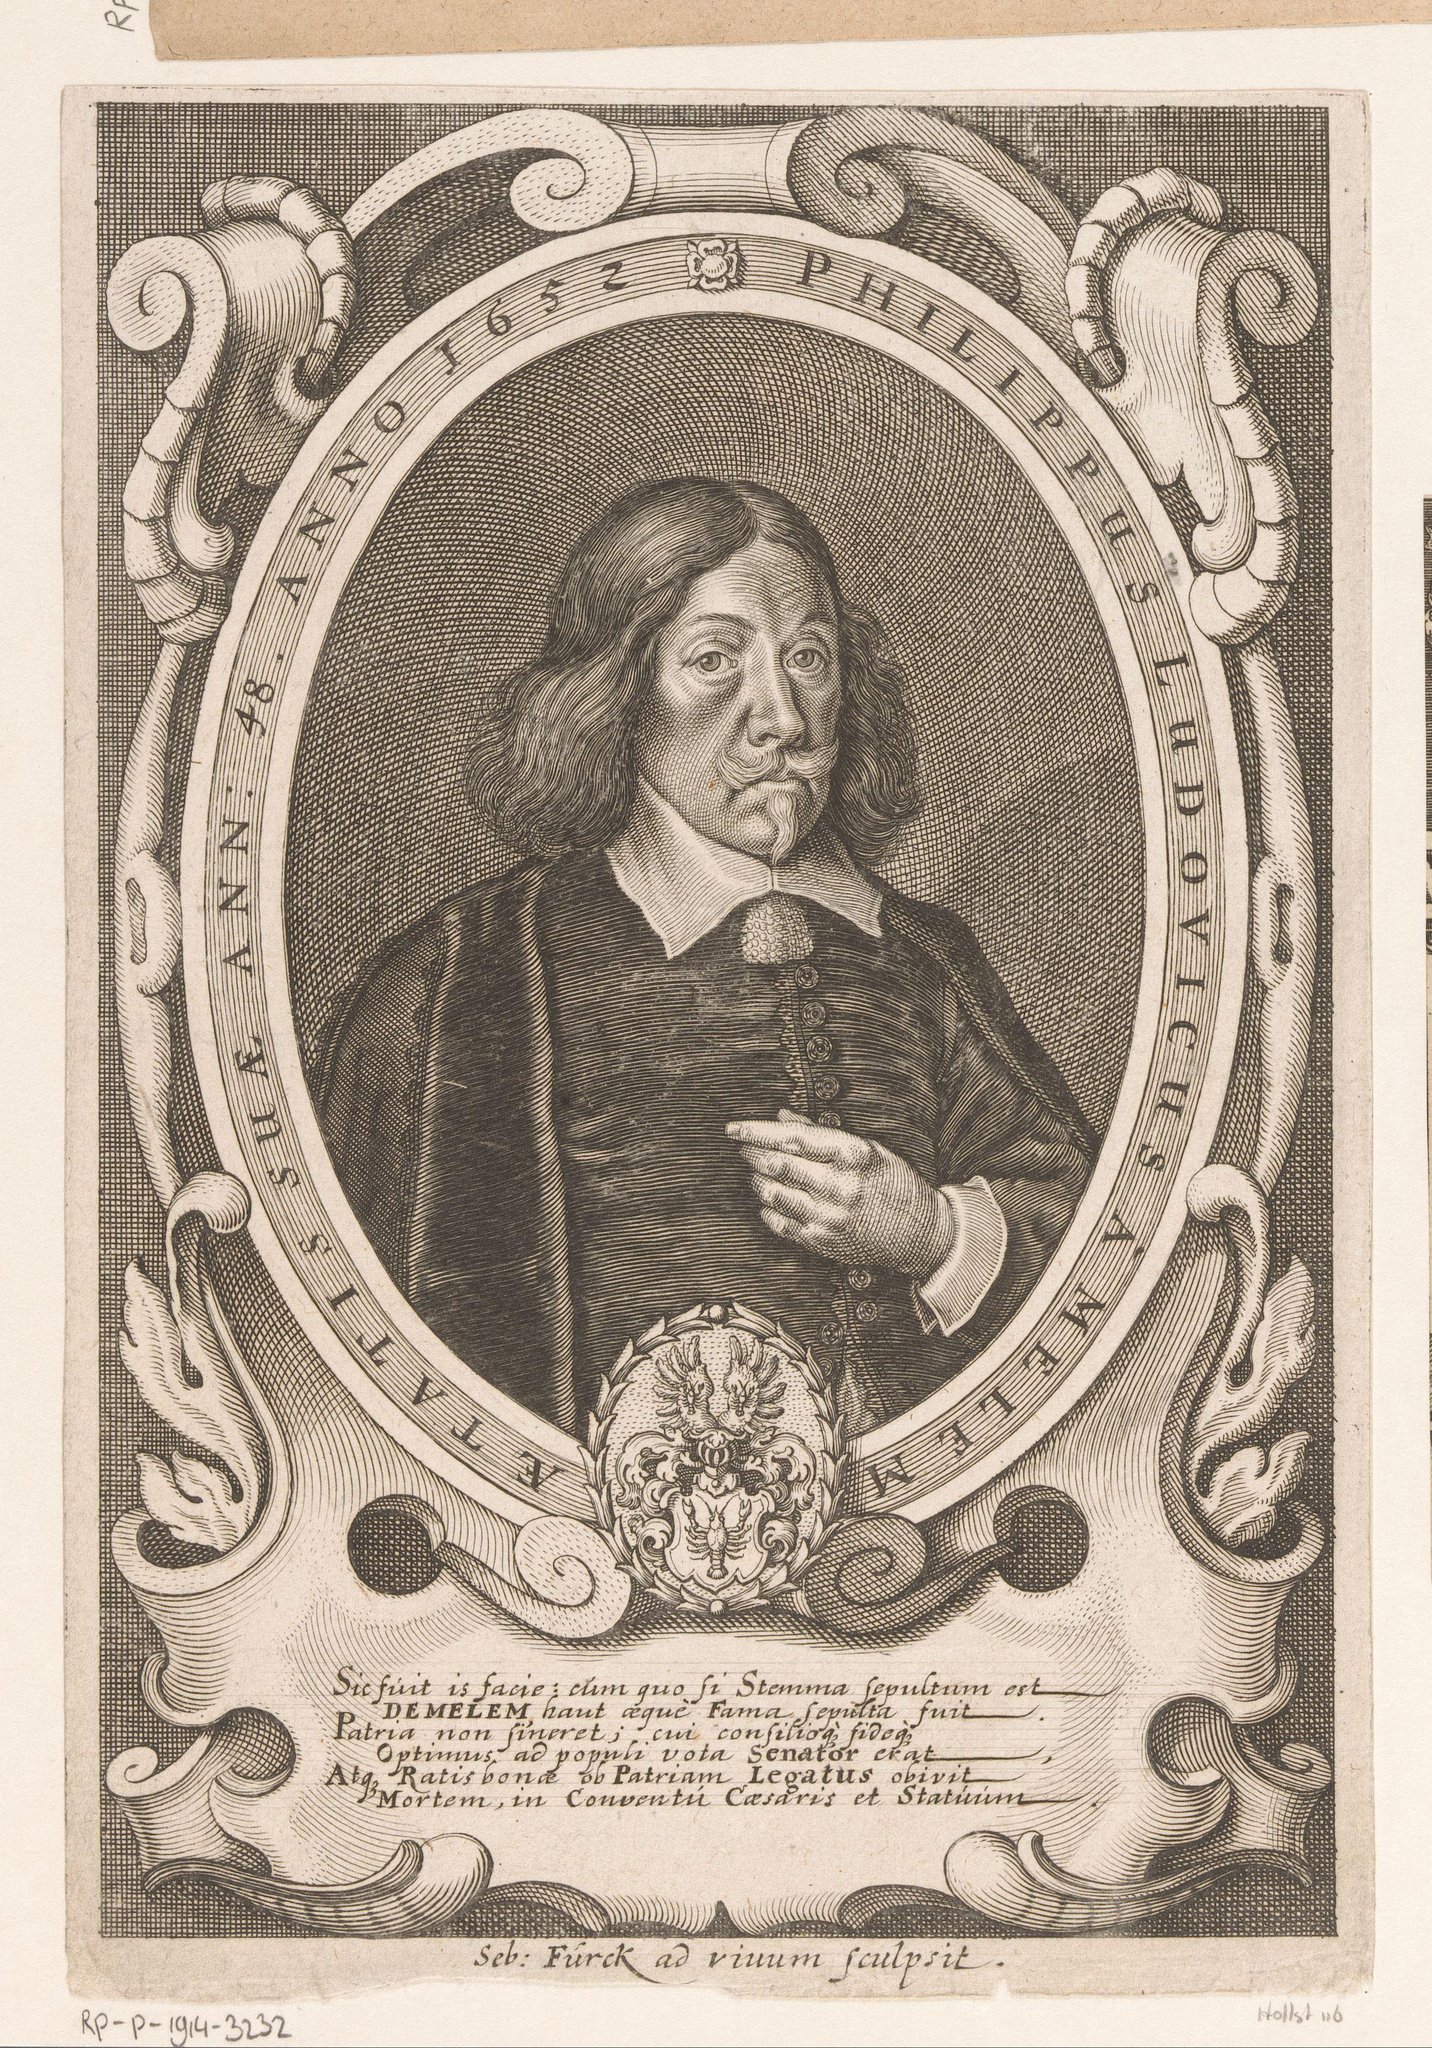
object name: print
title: Portret van Philipp Ludwig Melem op 48-jarige leeftijd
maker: sebastian furck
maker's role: print maker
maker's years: 1600-1655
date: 1652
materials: paper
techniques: engraving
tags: historical persons, ornament ~ cartouche, armorial bearing, heraldry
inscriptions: collector's mark: Lugt 2228